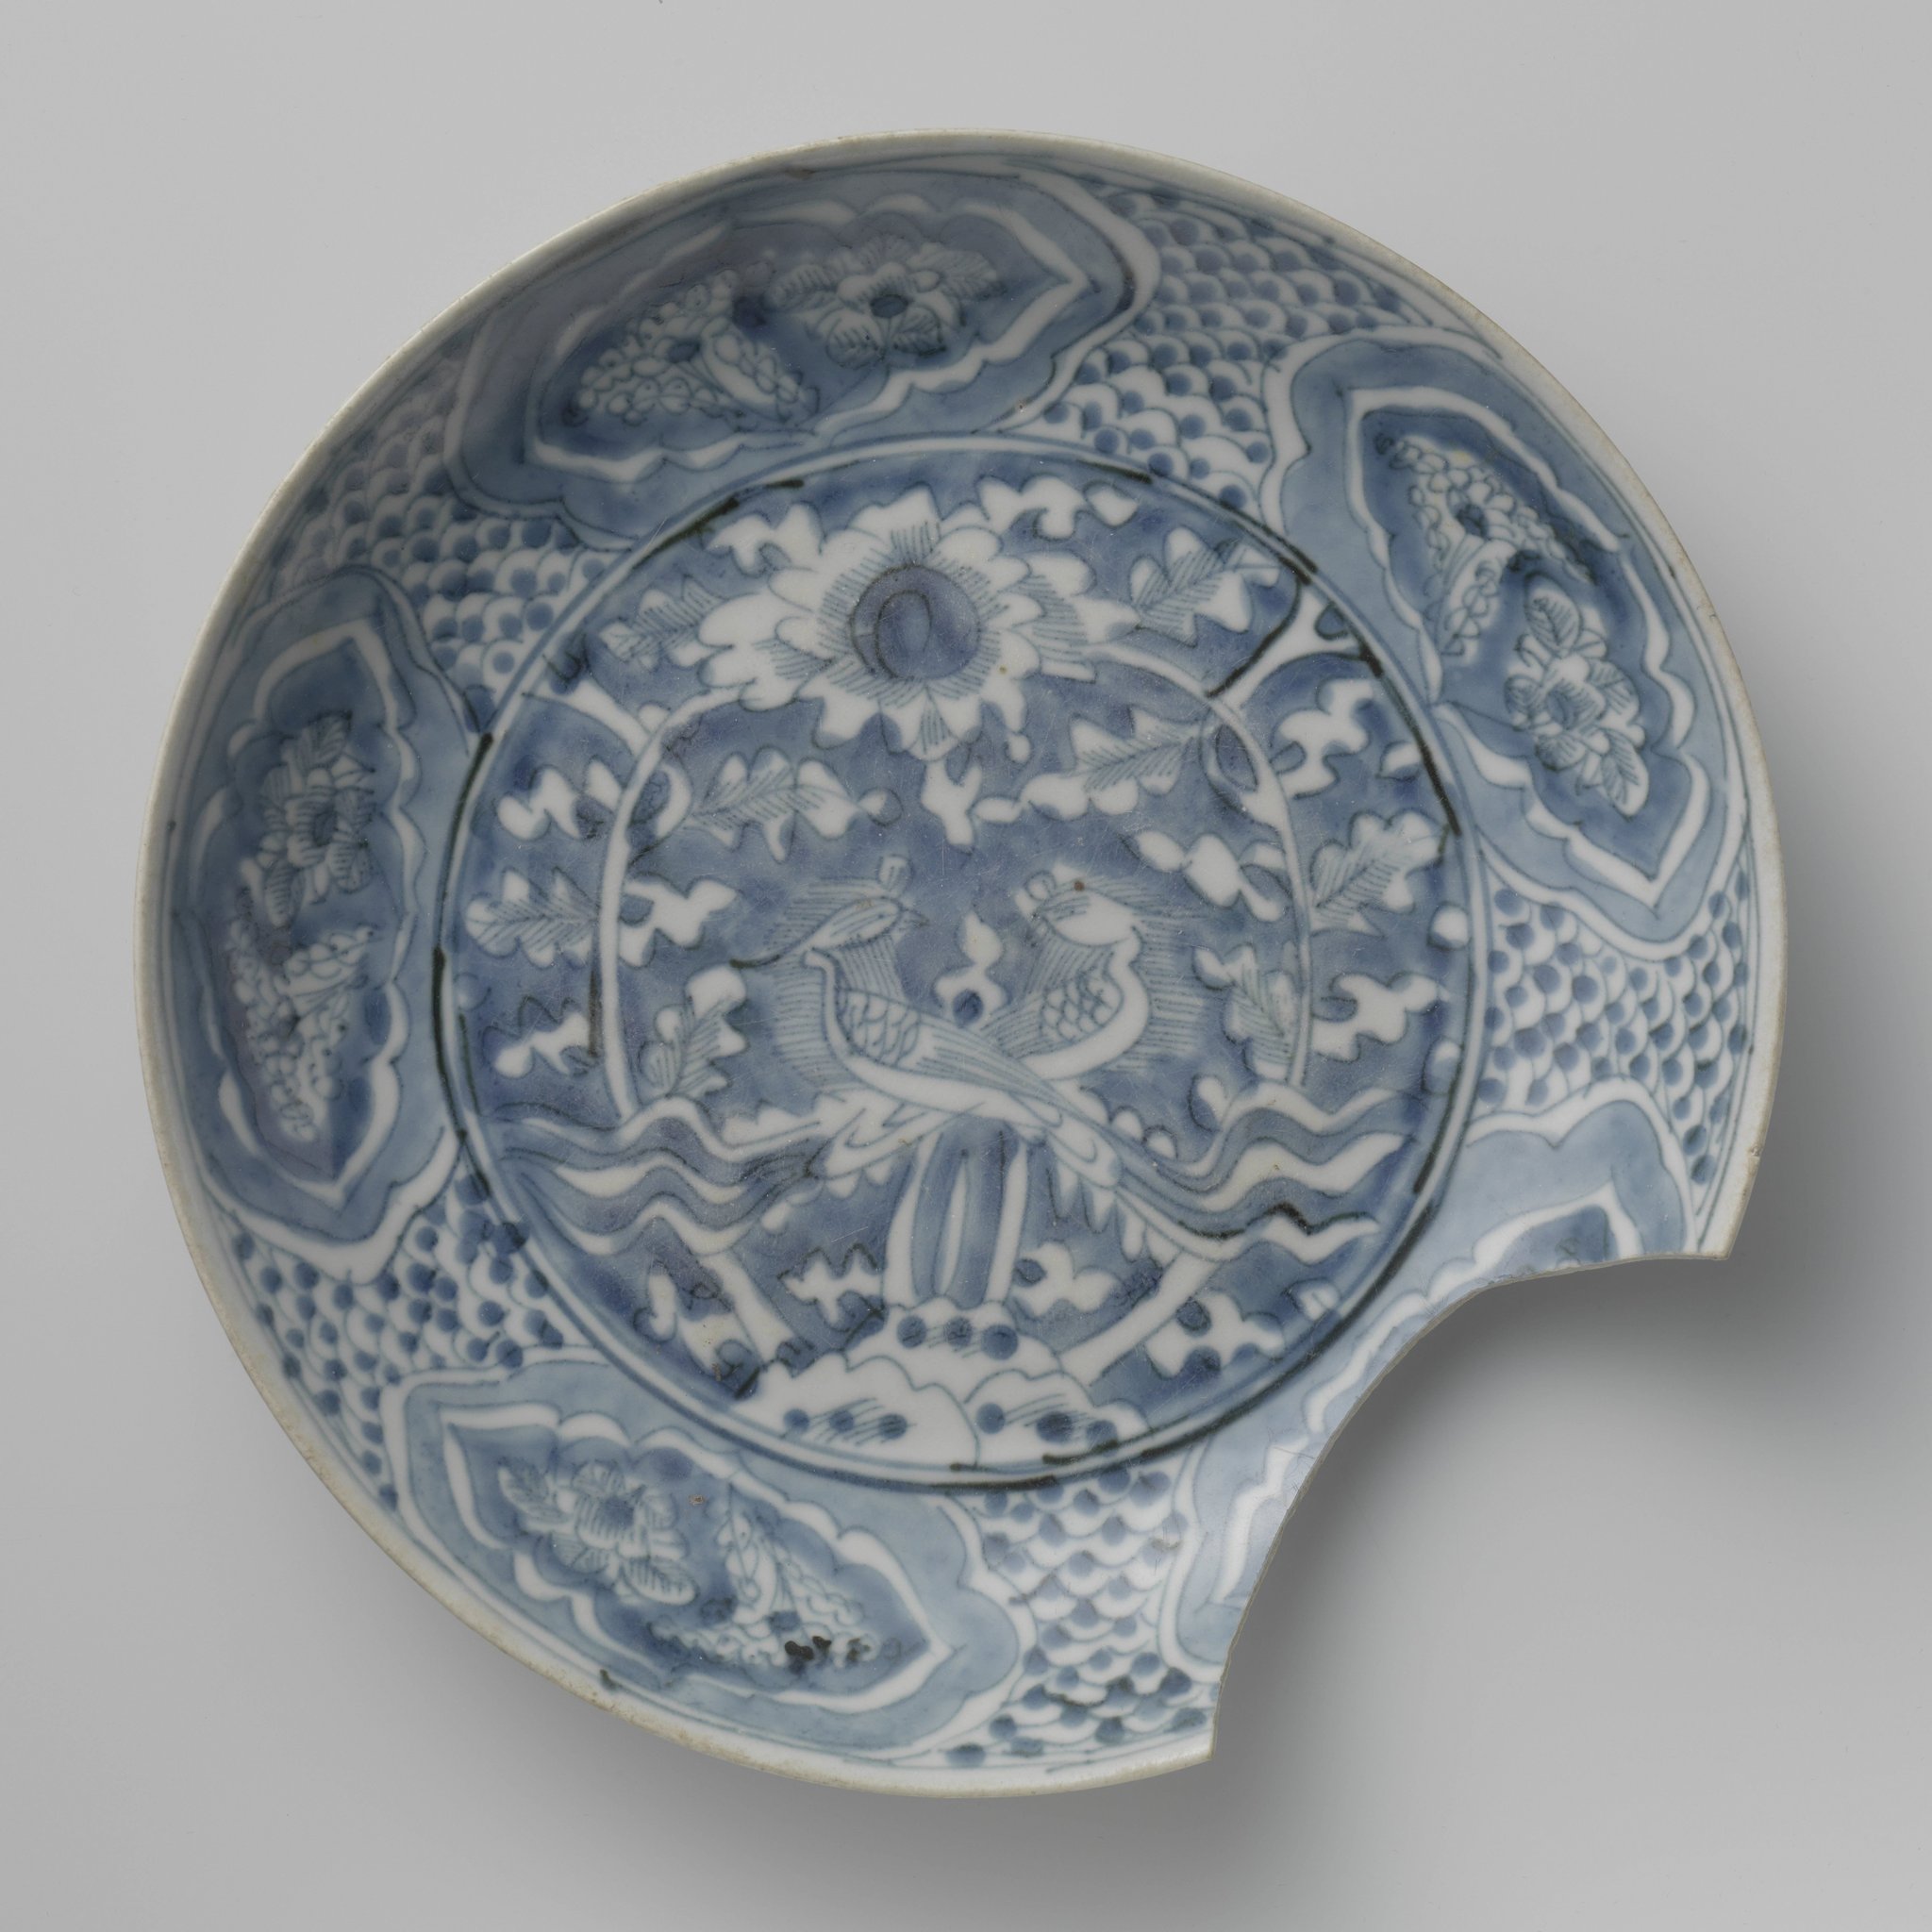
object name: plate dish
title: Bord uit V.O.C.-schip de 'Witte Leeuw'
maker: Anonymous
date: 1613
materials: porcelain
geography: swatow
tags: verenigde oostindische compagnie, sint-helena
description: A dish. In the centre two phoenix standing with crossed bodies. The background is completely filled with leaf scrolls and leaves. On the walls are five foliated medallions each filled with flowers. The area in between is filled up with a scale pattern. The whole decoration is done in white on blue.